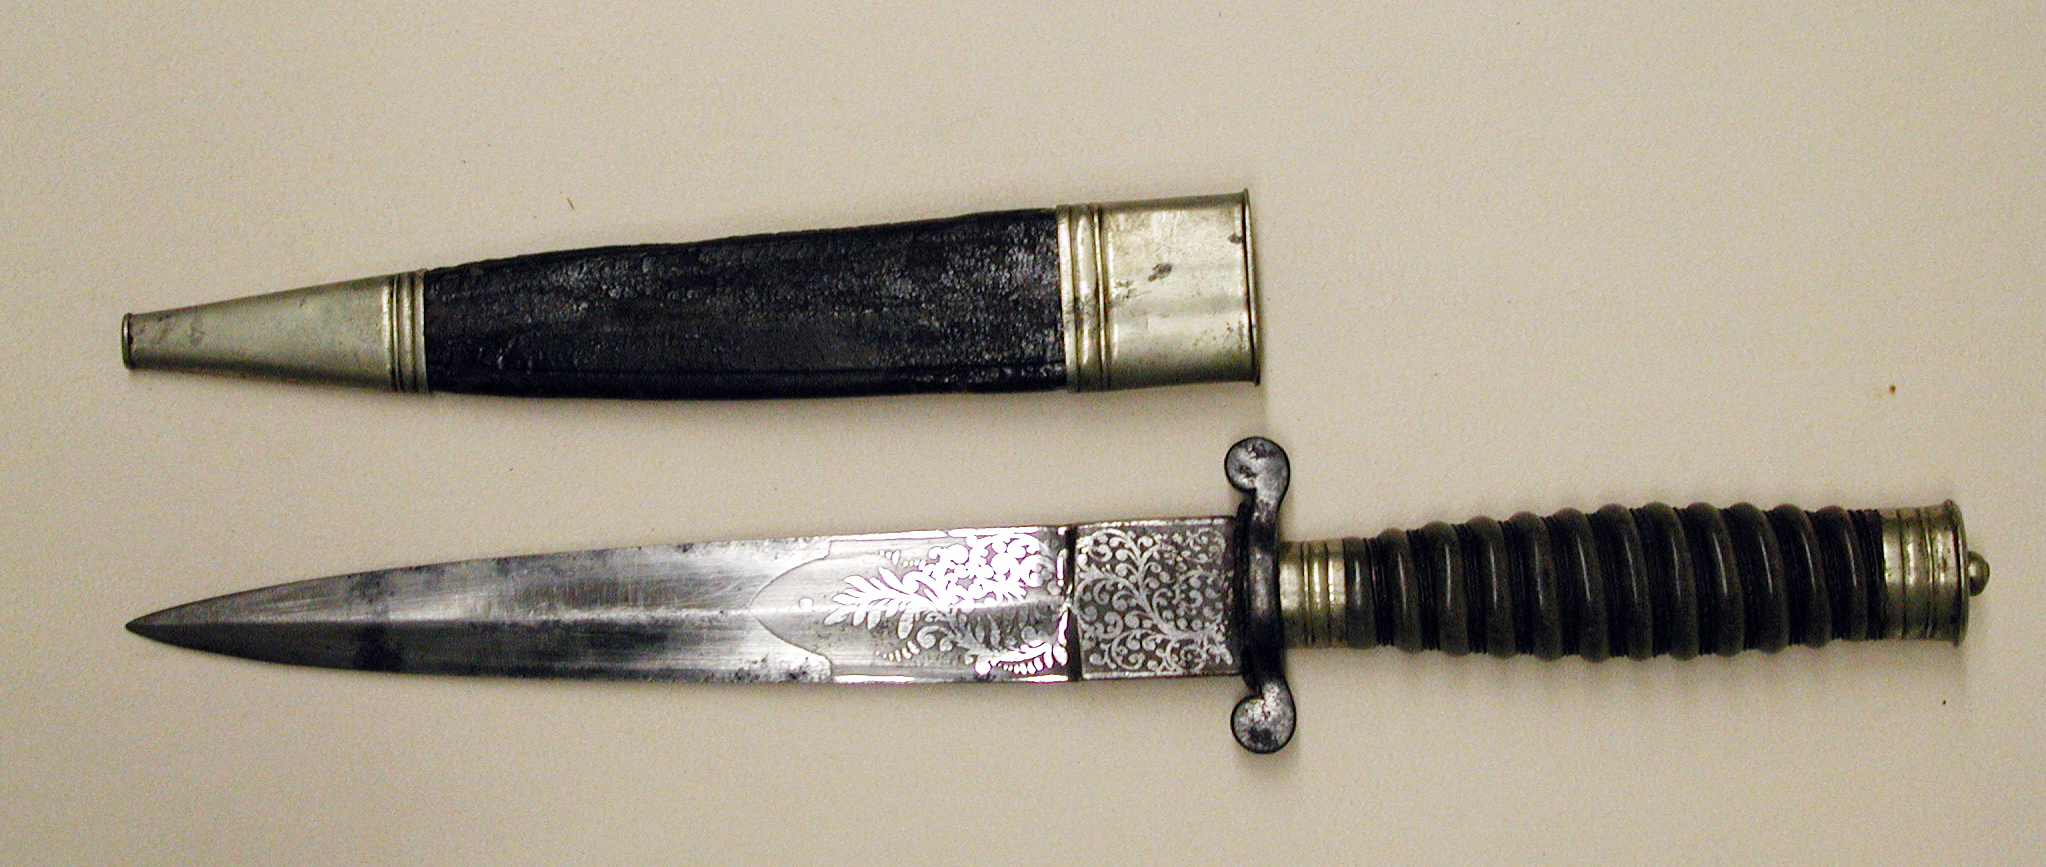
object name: dirk with sheath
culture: spanish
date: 1801-1833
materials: brass, copper, horn, leather, steel, metal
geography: spain